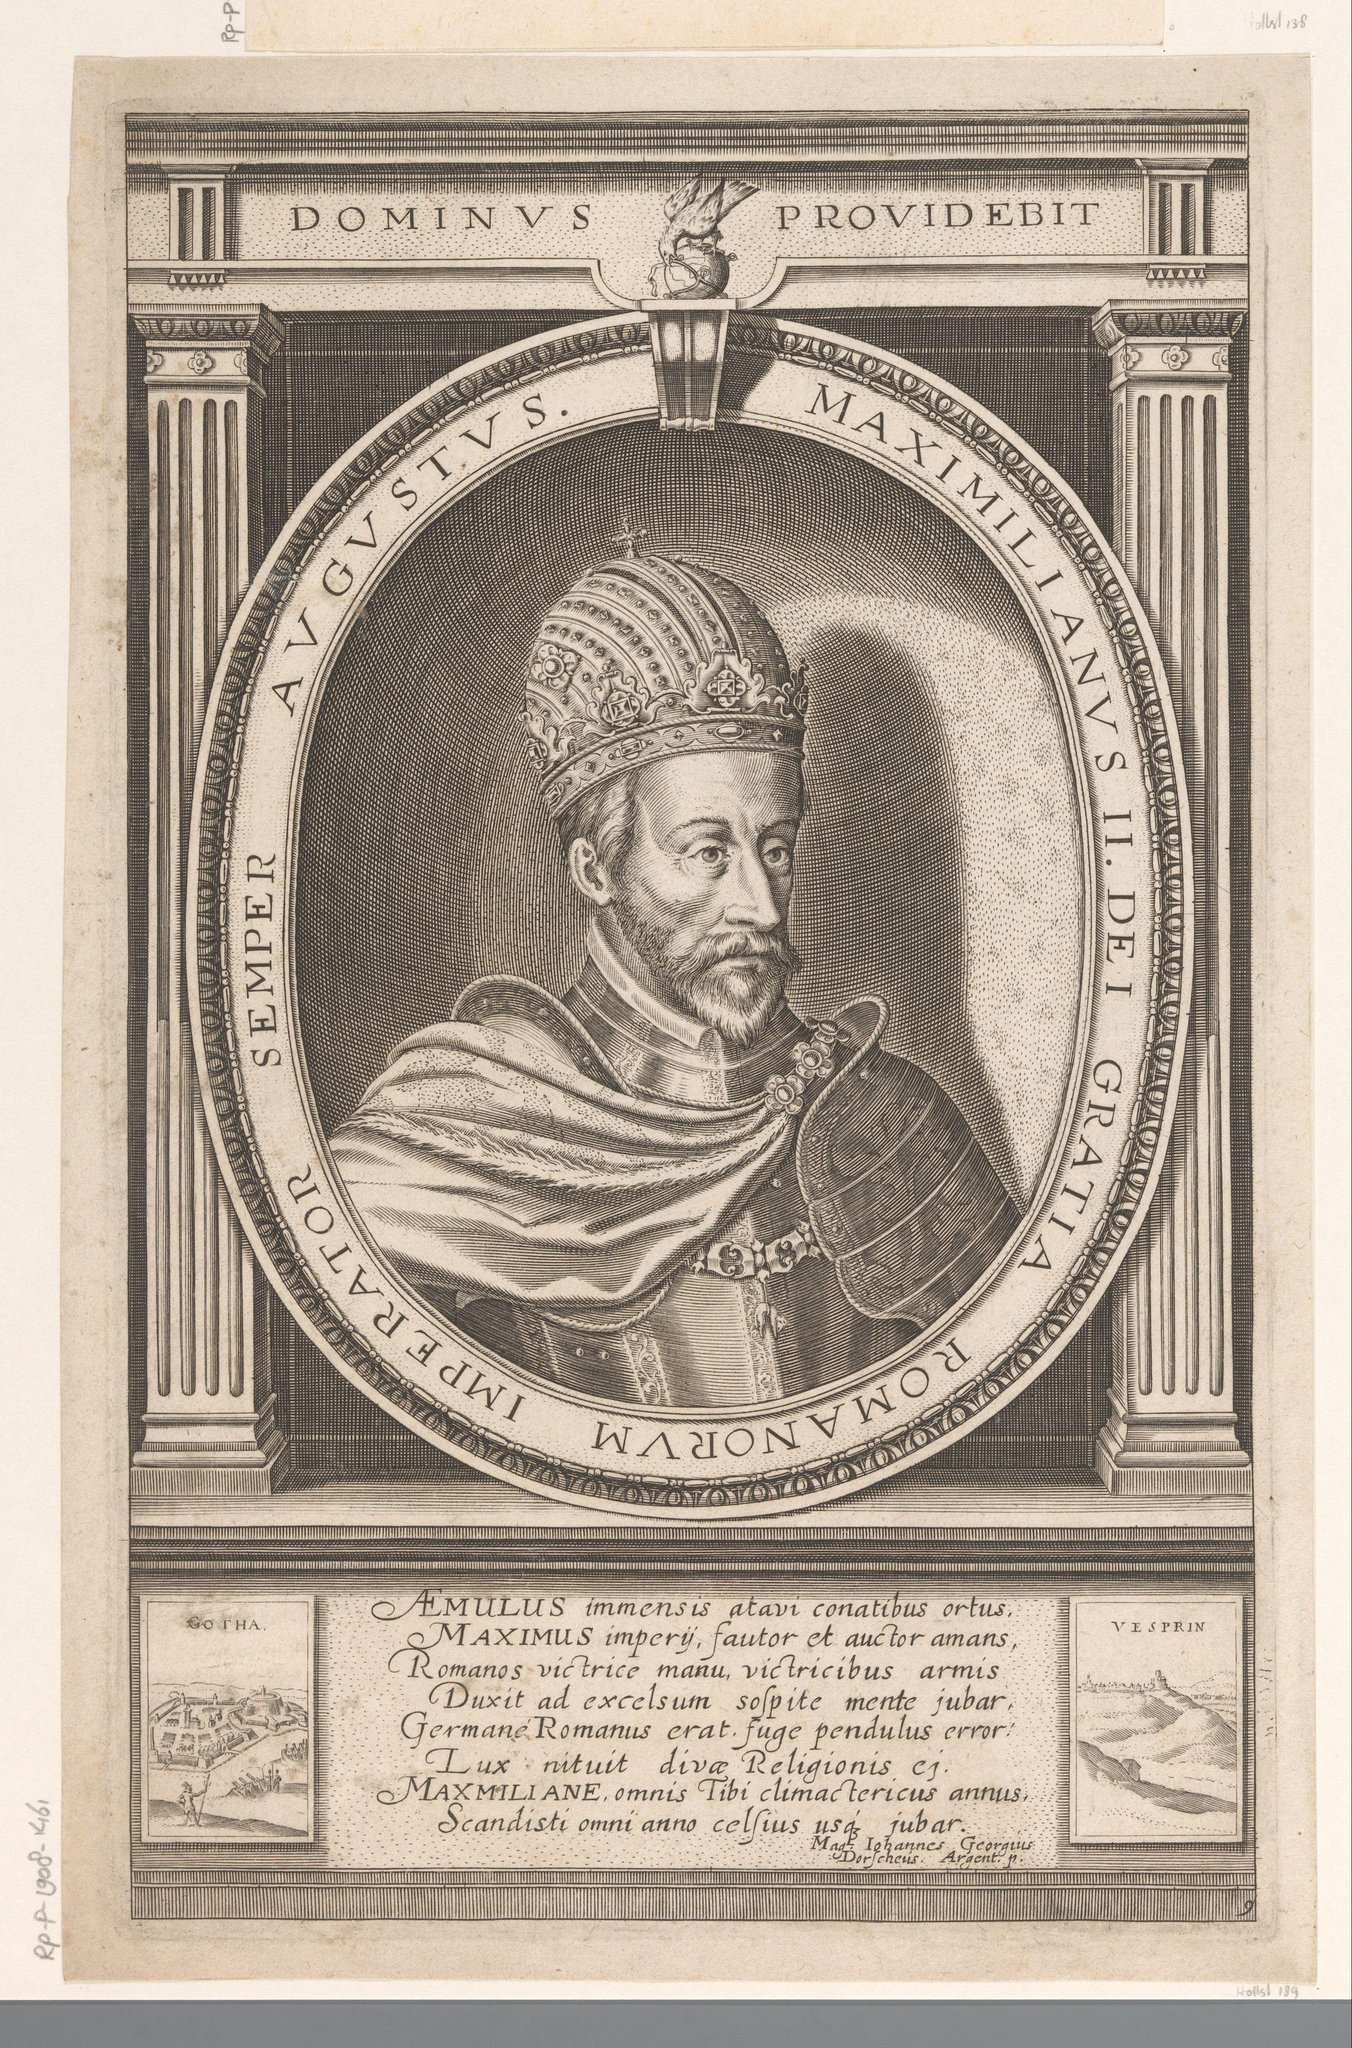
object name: print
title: Portret van keizer Maximiliaan II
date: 1660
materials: paper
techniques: engraving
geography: straatsburg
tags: vienna, maximiliaan ii (keizer van heilige roomse rijk), predatory birds: eagle, historical persons, emperor, knighthood order of the golden fleece - insignia of a knighthood order, e.g.: badge, chain (with name of order)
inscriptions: collector's mark: Lugt 2228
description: Prent uit: Aquila Austriaca Das ist Historische Beschreibung und Abbildungen Aller Römischen Kaiser und Könige (...). Neurenberg: Paul Fürst, [1660].